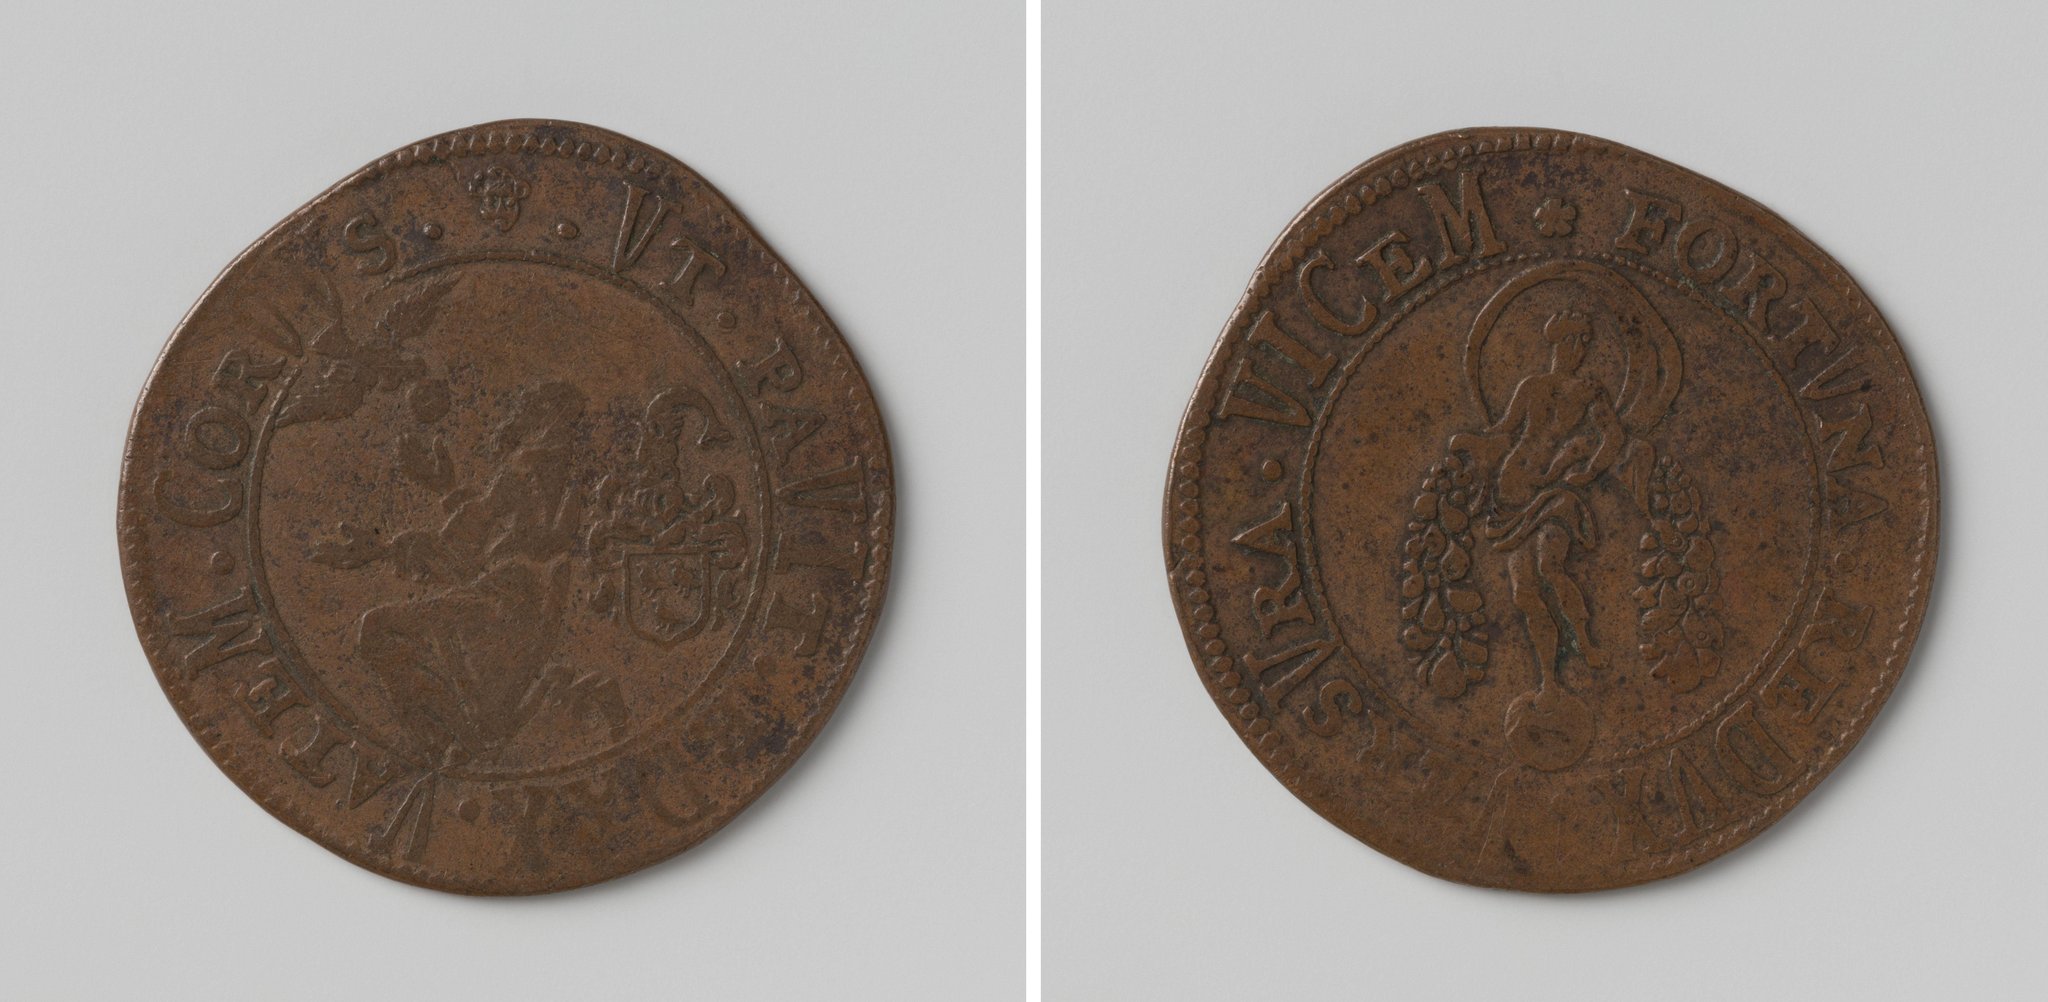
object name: jeton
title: Voorspoed voor het Spaanse leger, rekenpenning ter ere van Engelbrecht Raveschott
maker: Anonymous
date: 1636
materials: copper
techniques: striking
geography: brussels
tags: engelbrecht raveschott, tachtigjarige oorlog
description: Koperen penning. Voorzijde: profeet Elia wordt gevoed door een raaf; achter hem: gehelmd wapenschild binnen omschrift. Keerzijde: Fortuin met sluier boven hoofd, staande op globe houdt gevulde hoorn van overvloed in elk van beide handen binnen omschrift.